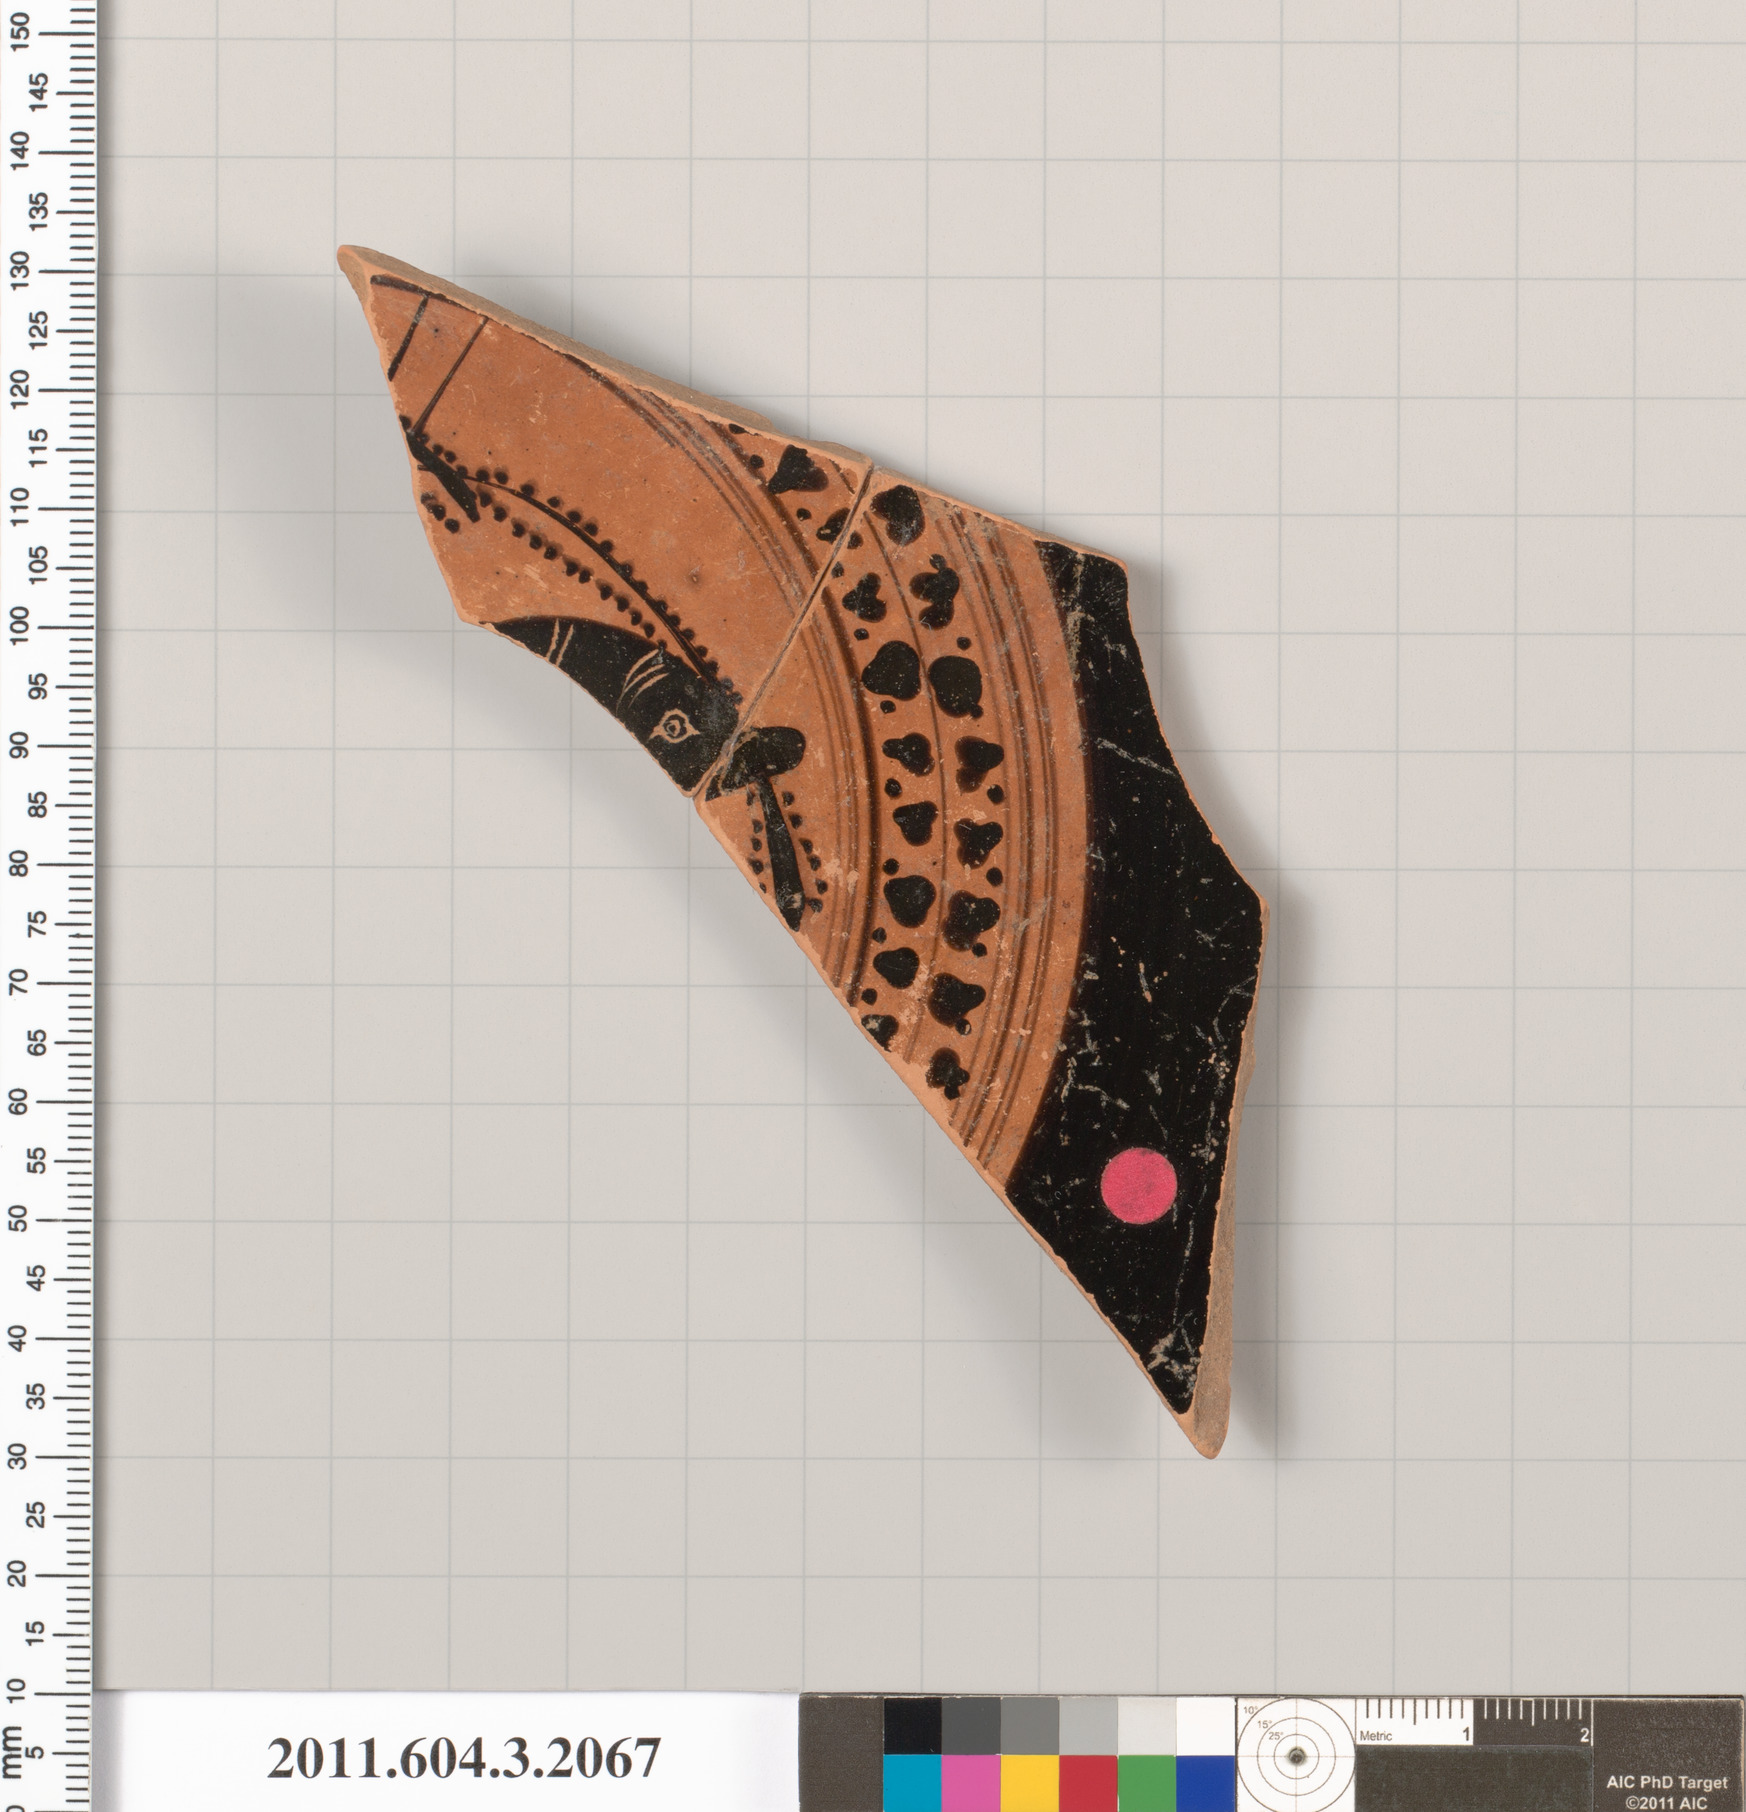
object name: kylix fragment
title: Terracotta fragment of a kylix (drinking cup)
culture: greek, attic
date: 525-501 BCE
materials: terracotta